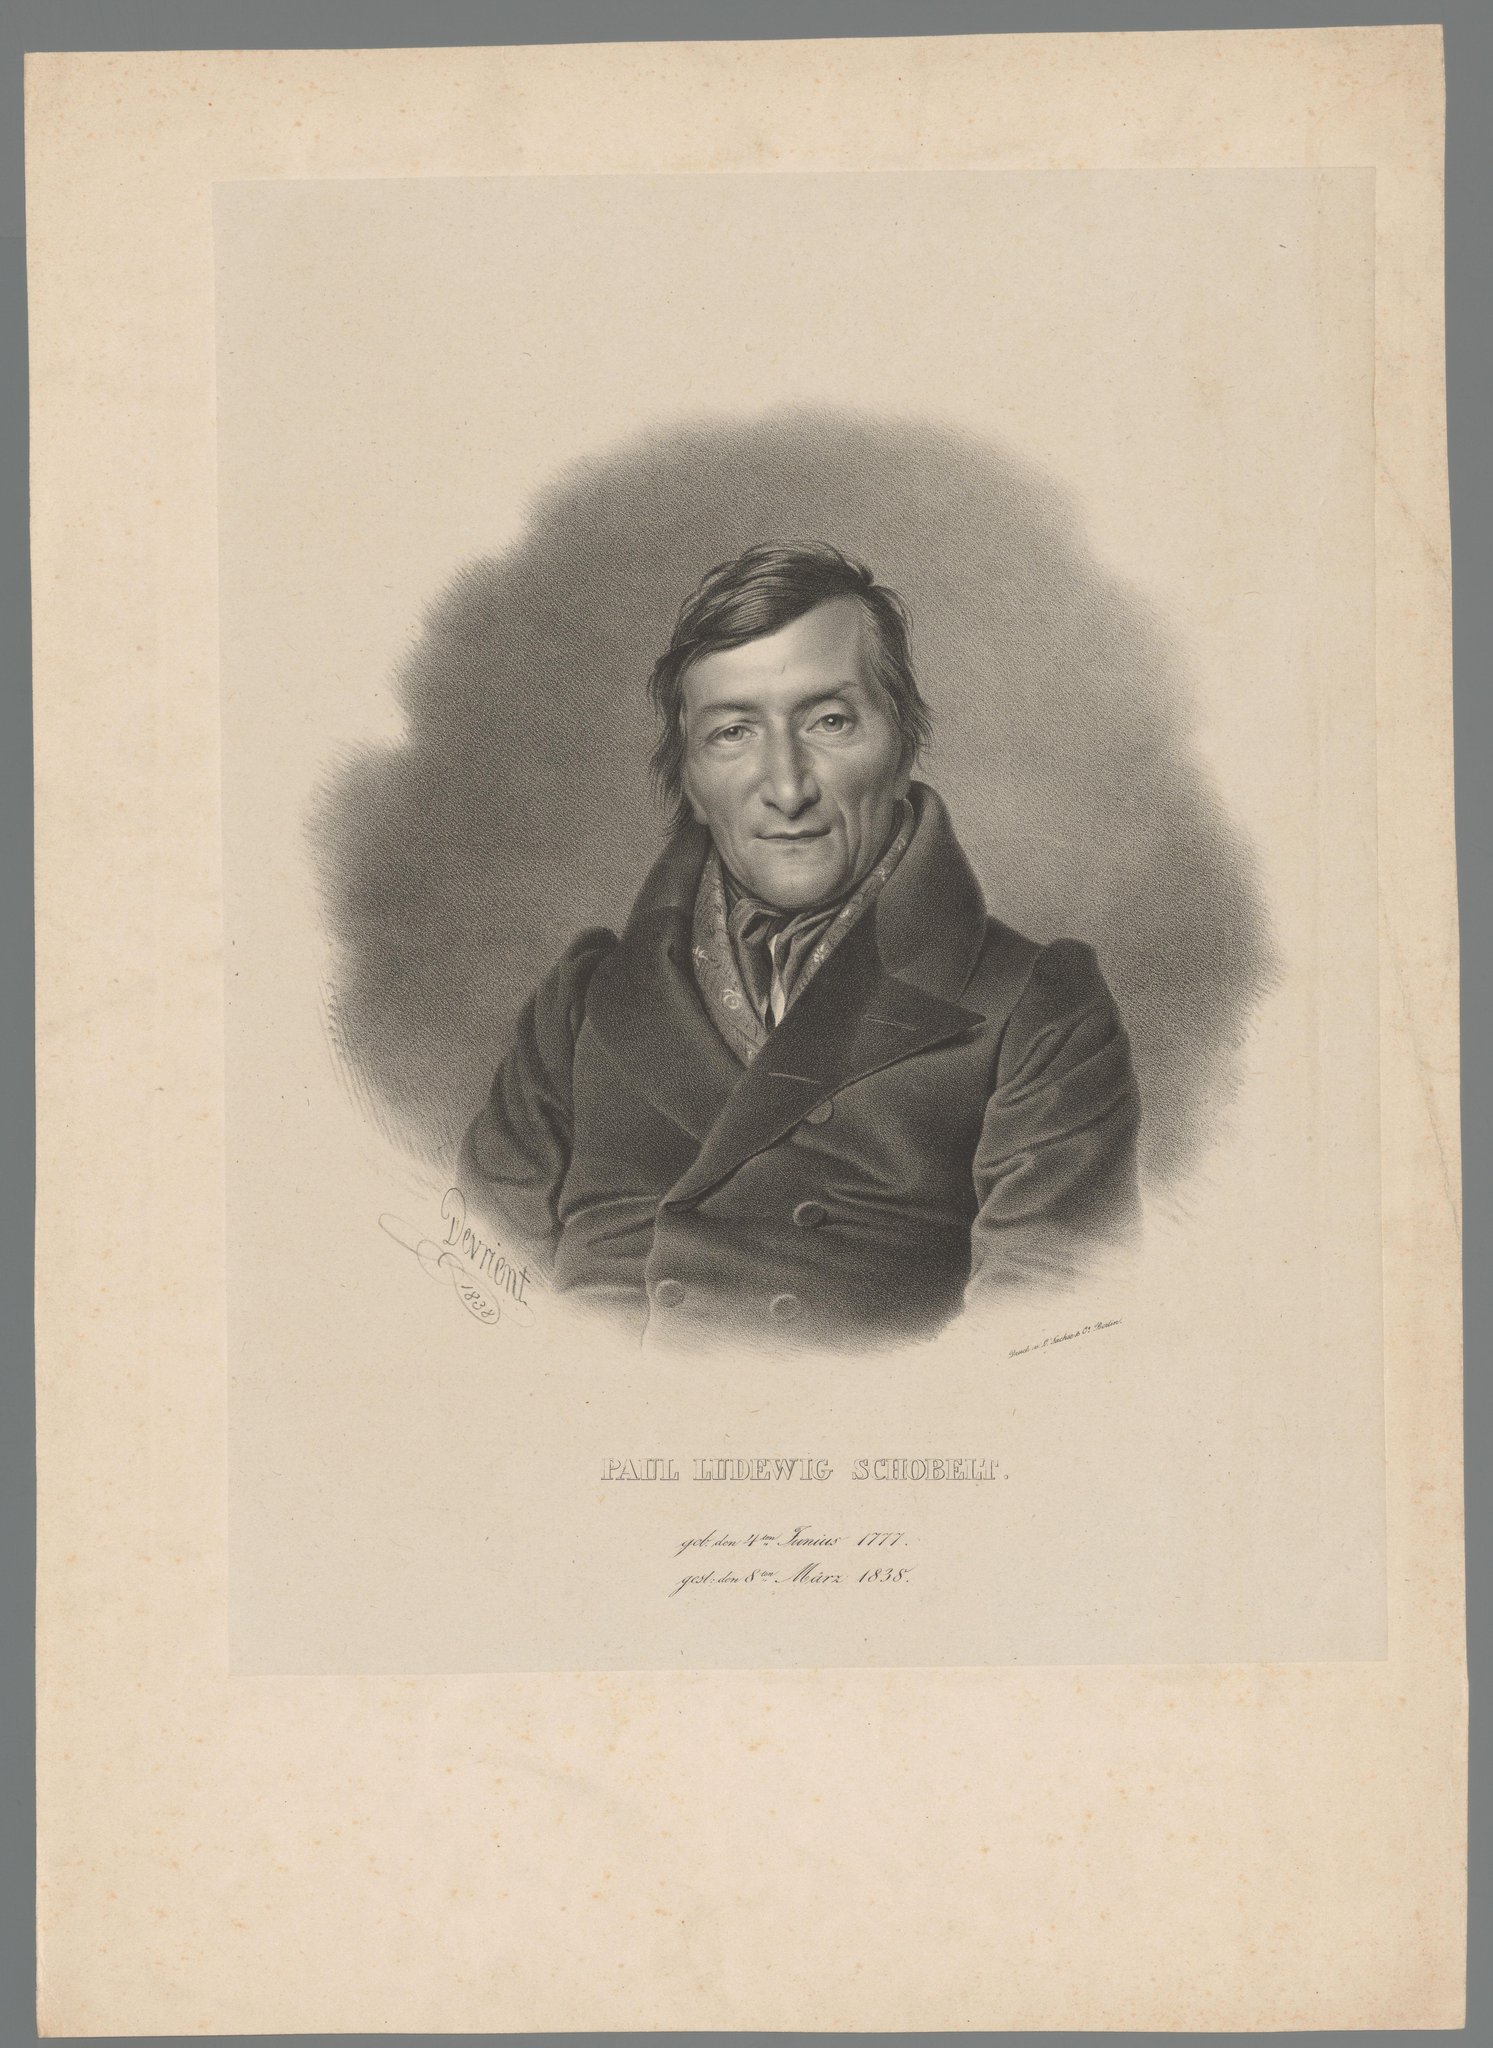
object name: print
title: Portret van Paul Ludewig Schobelt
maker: wilhelm devrient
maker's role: print maker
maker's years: 1799-1866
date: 1838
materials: paper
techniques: lithograph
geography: berlin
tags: historical persons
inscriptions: collector's mark: Lugt 2228